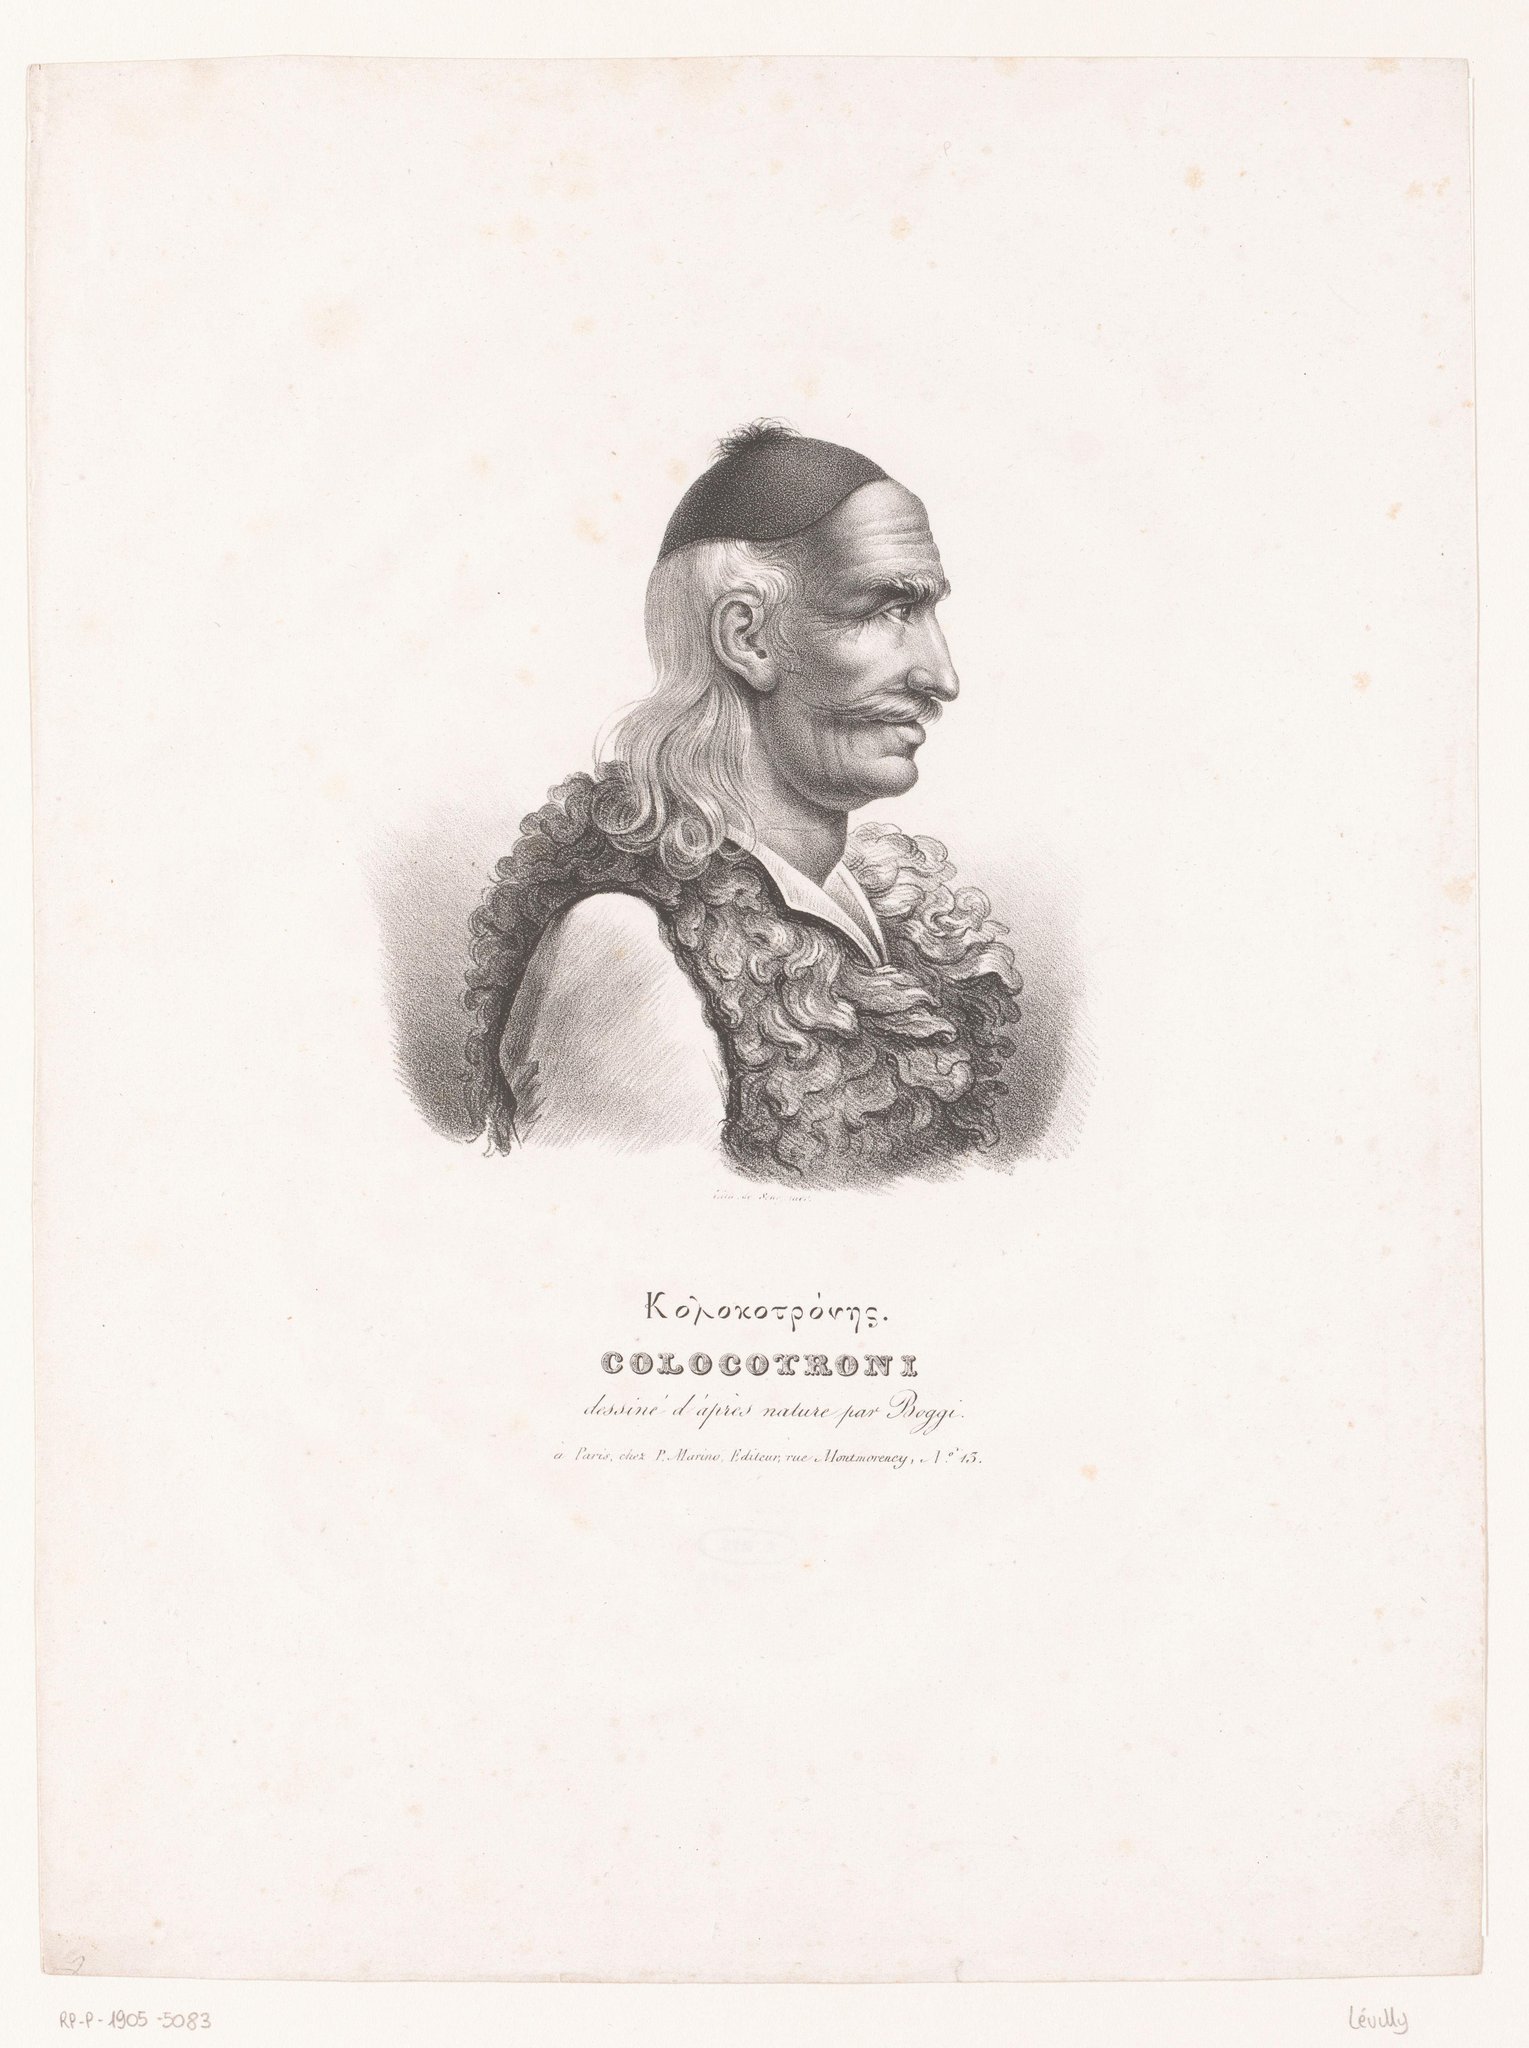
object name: print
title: Colocotroni, dessiné d'après nature par Boggi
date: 1827-1829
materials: paper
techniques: lithograph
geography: paris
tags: historical persons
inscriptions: collector's mark: Lugt 2228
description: Mogelijke toeschrijving aan Lévilly op basis van vergelijkbare prenten uit zijn oeuvre.